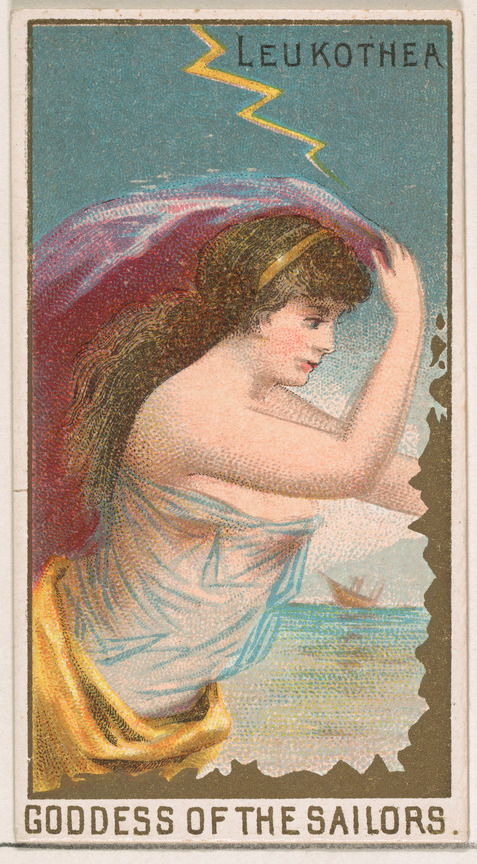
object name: print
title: Leukothea, Goddess of Sailors, from the Goddesses of the Greeks and Romans series (N188) issued by Wm. S. Kimball & Co.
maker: william s. kimball & company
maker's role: publisher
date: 1889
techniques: color lithograph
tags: profiles,goddess